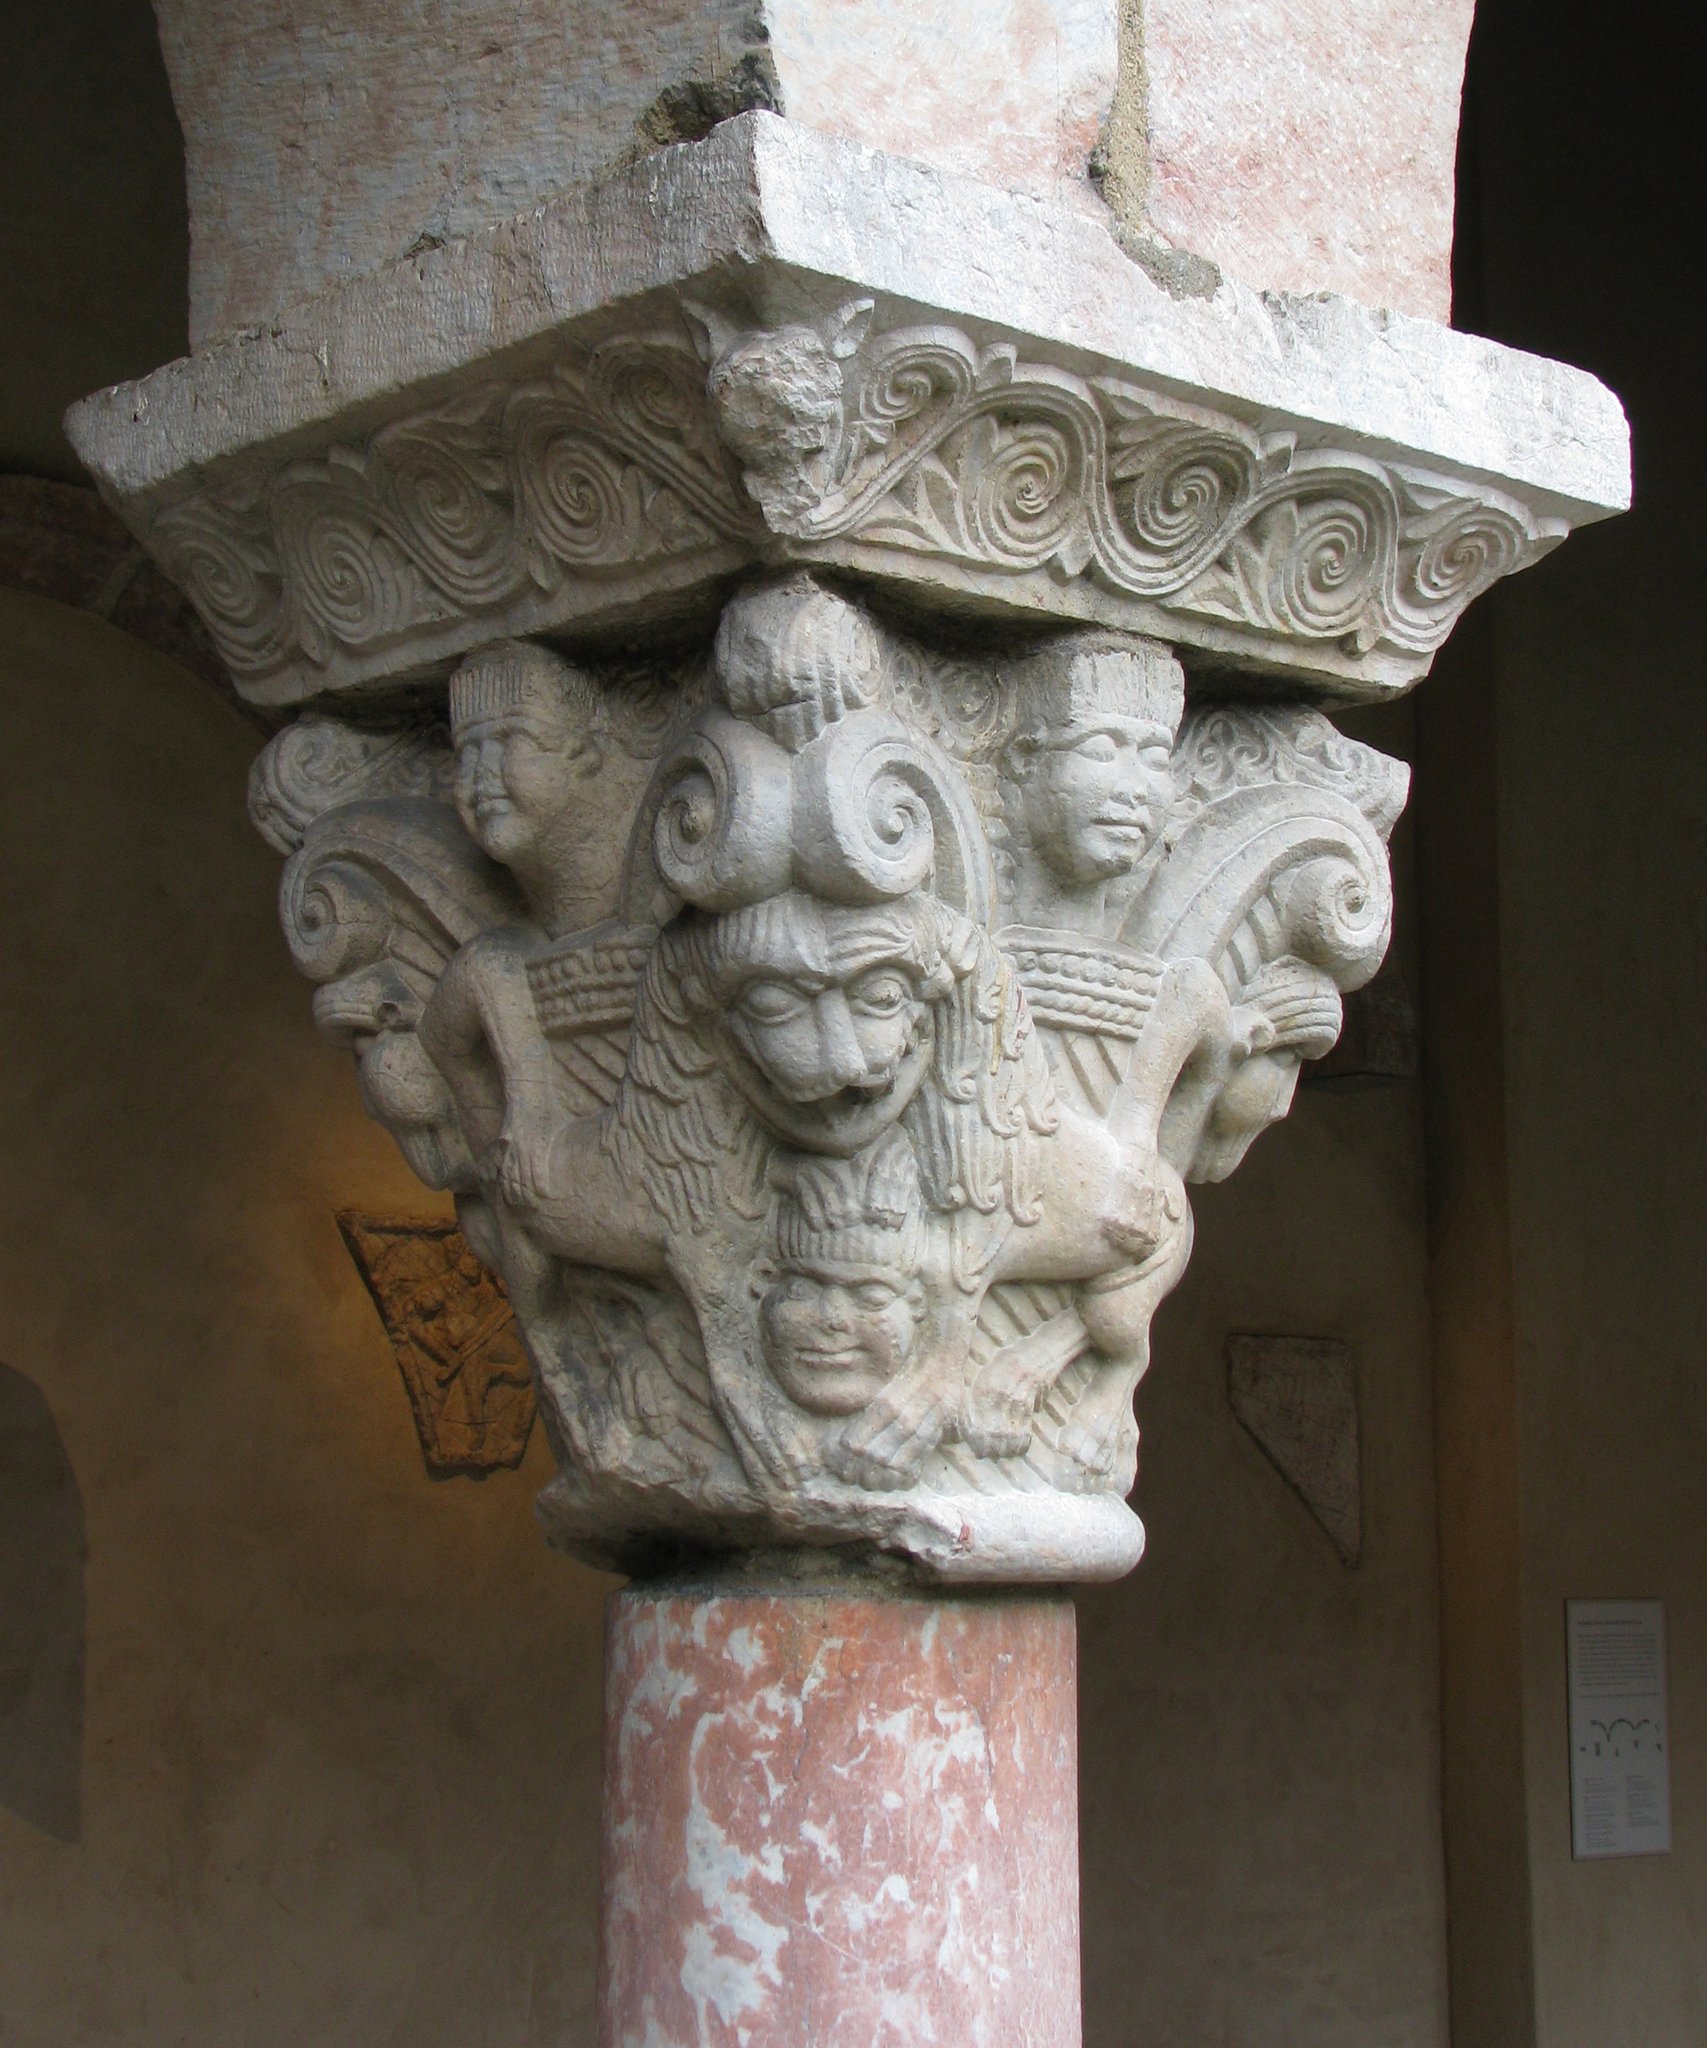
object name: capital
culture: catalan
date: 1130-1140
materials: marble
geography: france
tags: heads,lions